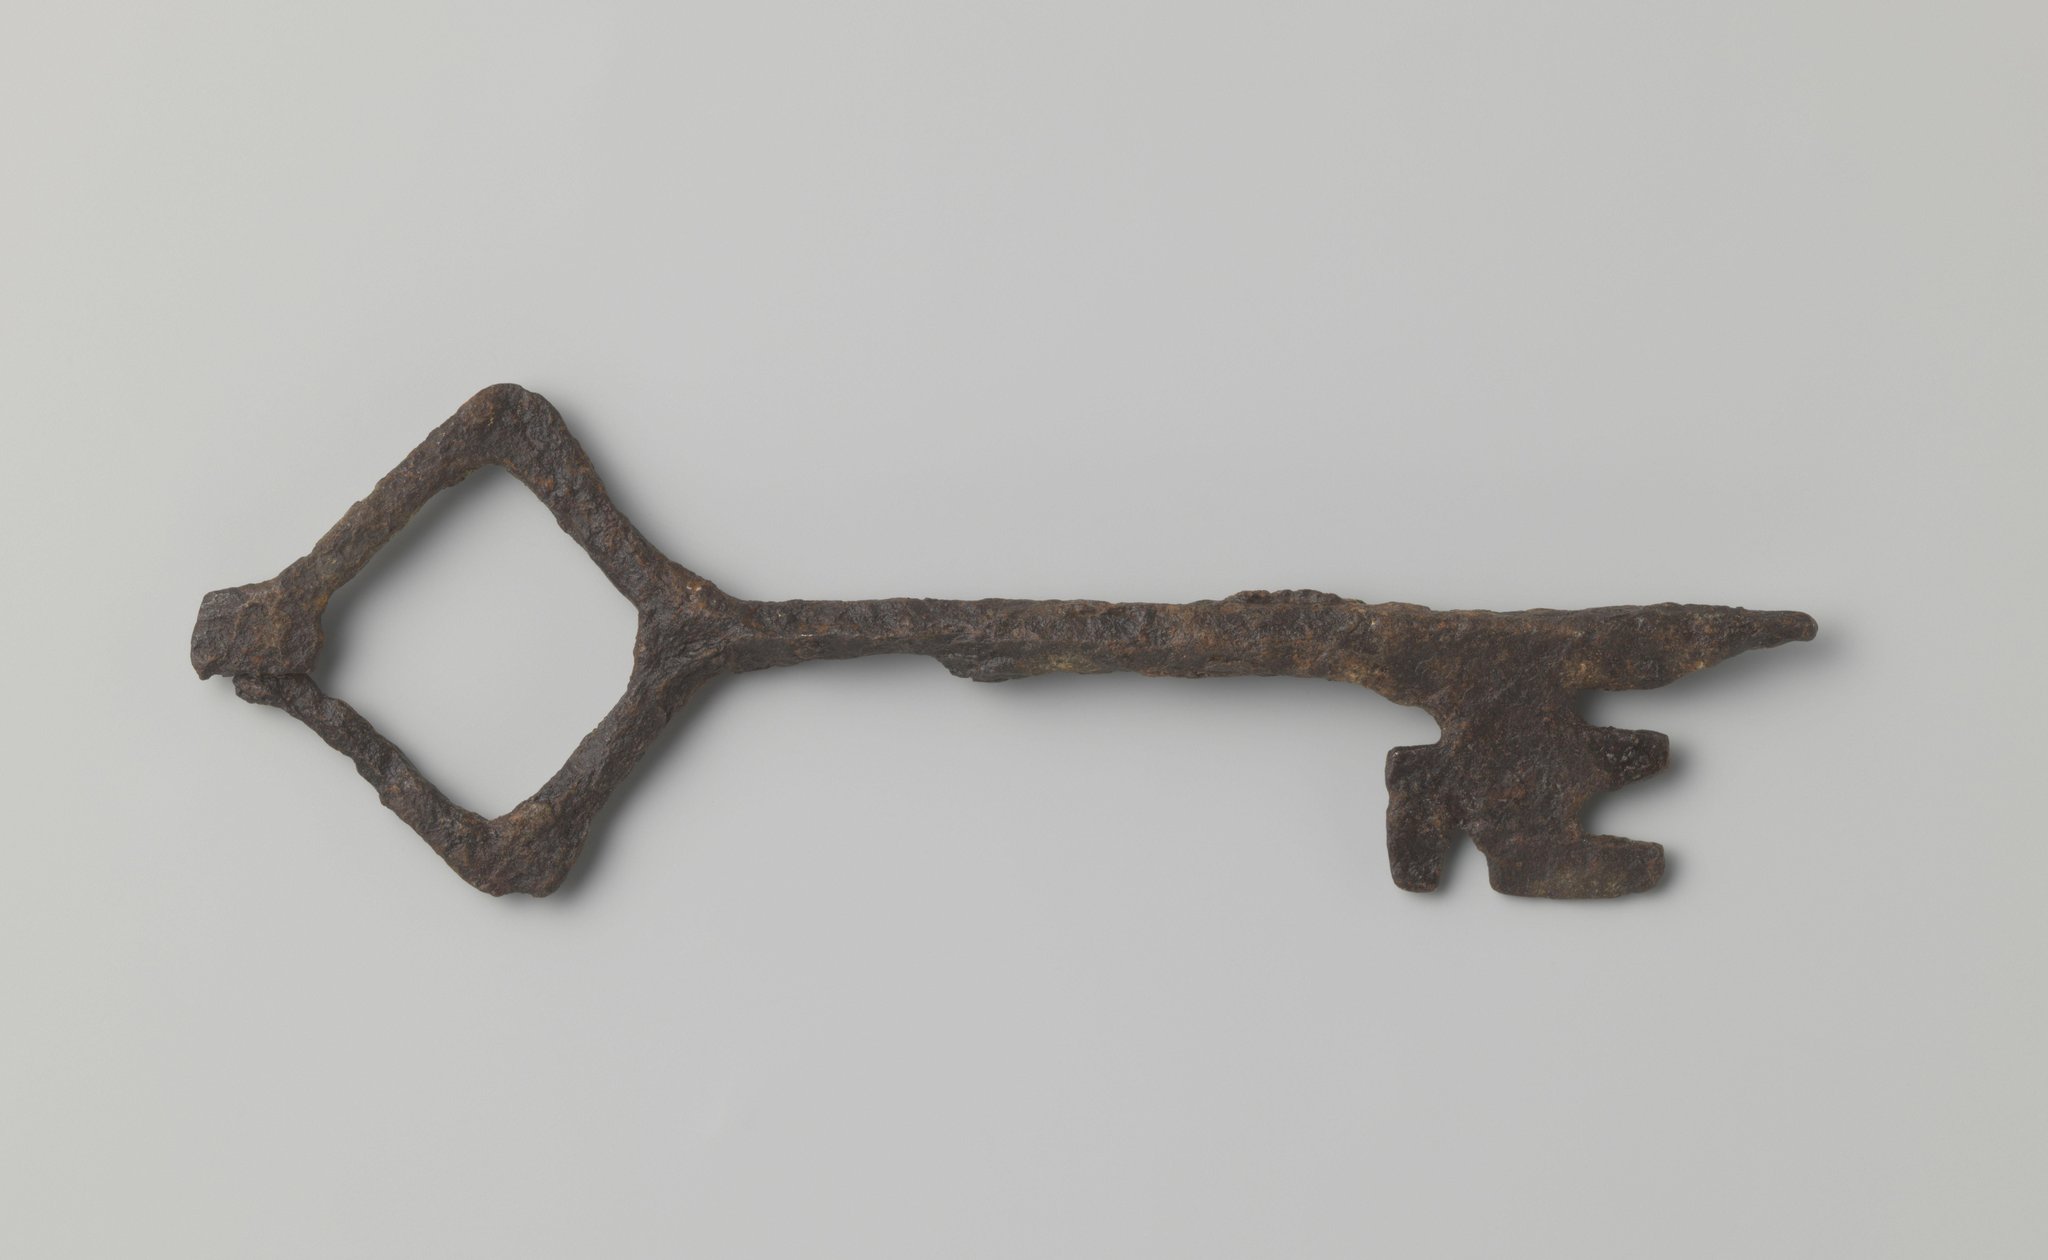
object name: key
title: Sleutel van ijzer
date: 1300-1400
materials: iron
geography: netherlands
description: Gesmeed ijzeren sleutel, ruitvormig oog, massieve pen, baard met vier rechte insnijdingen.